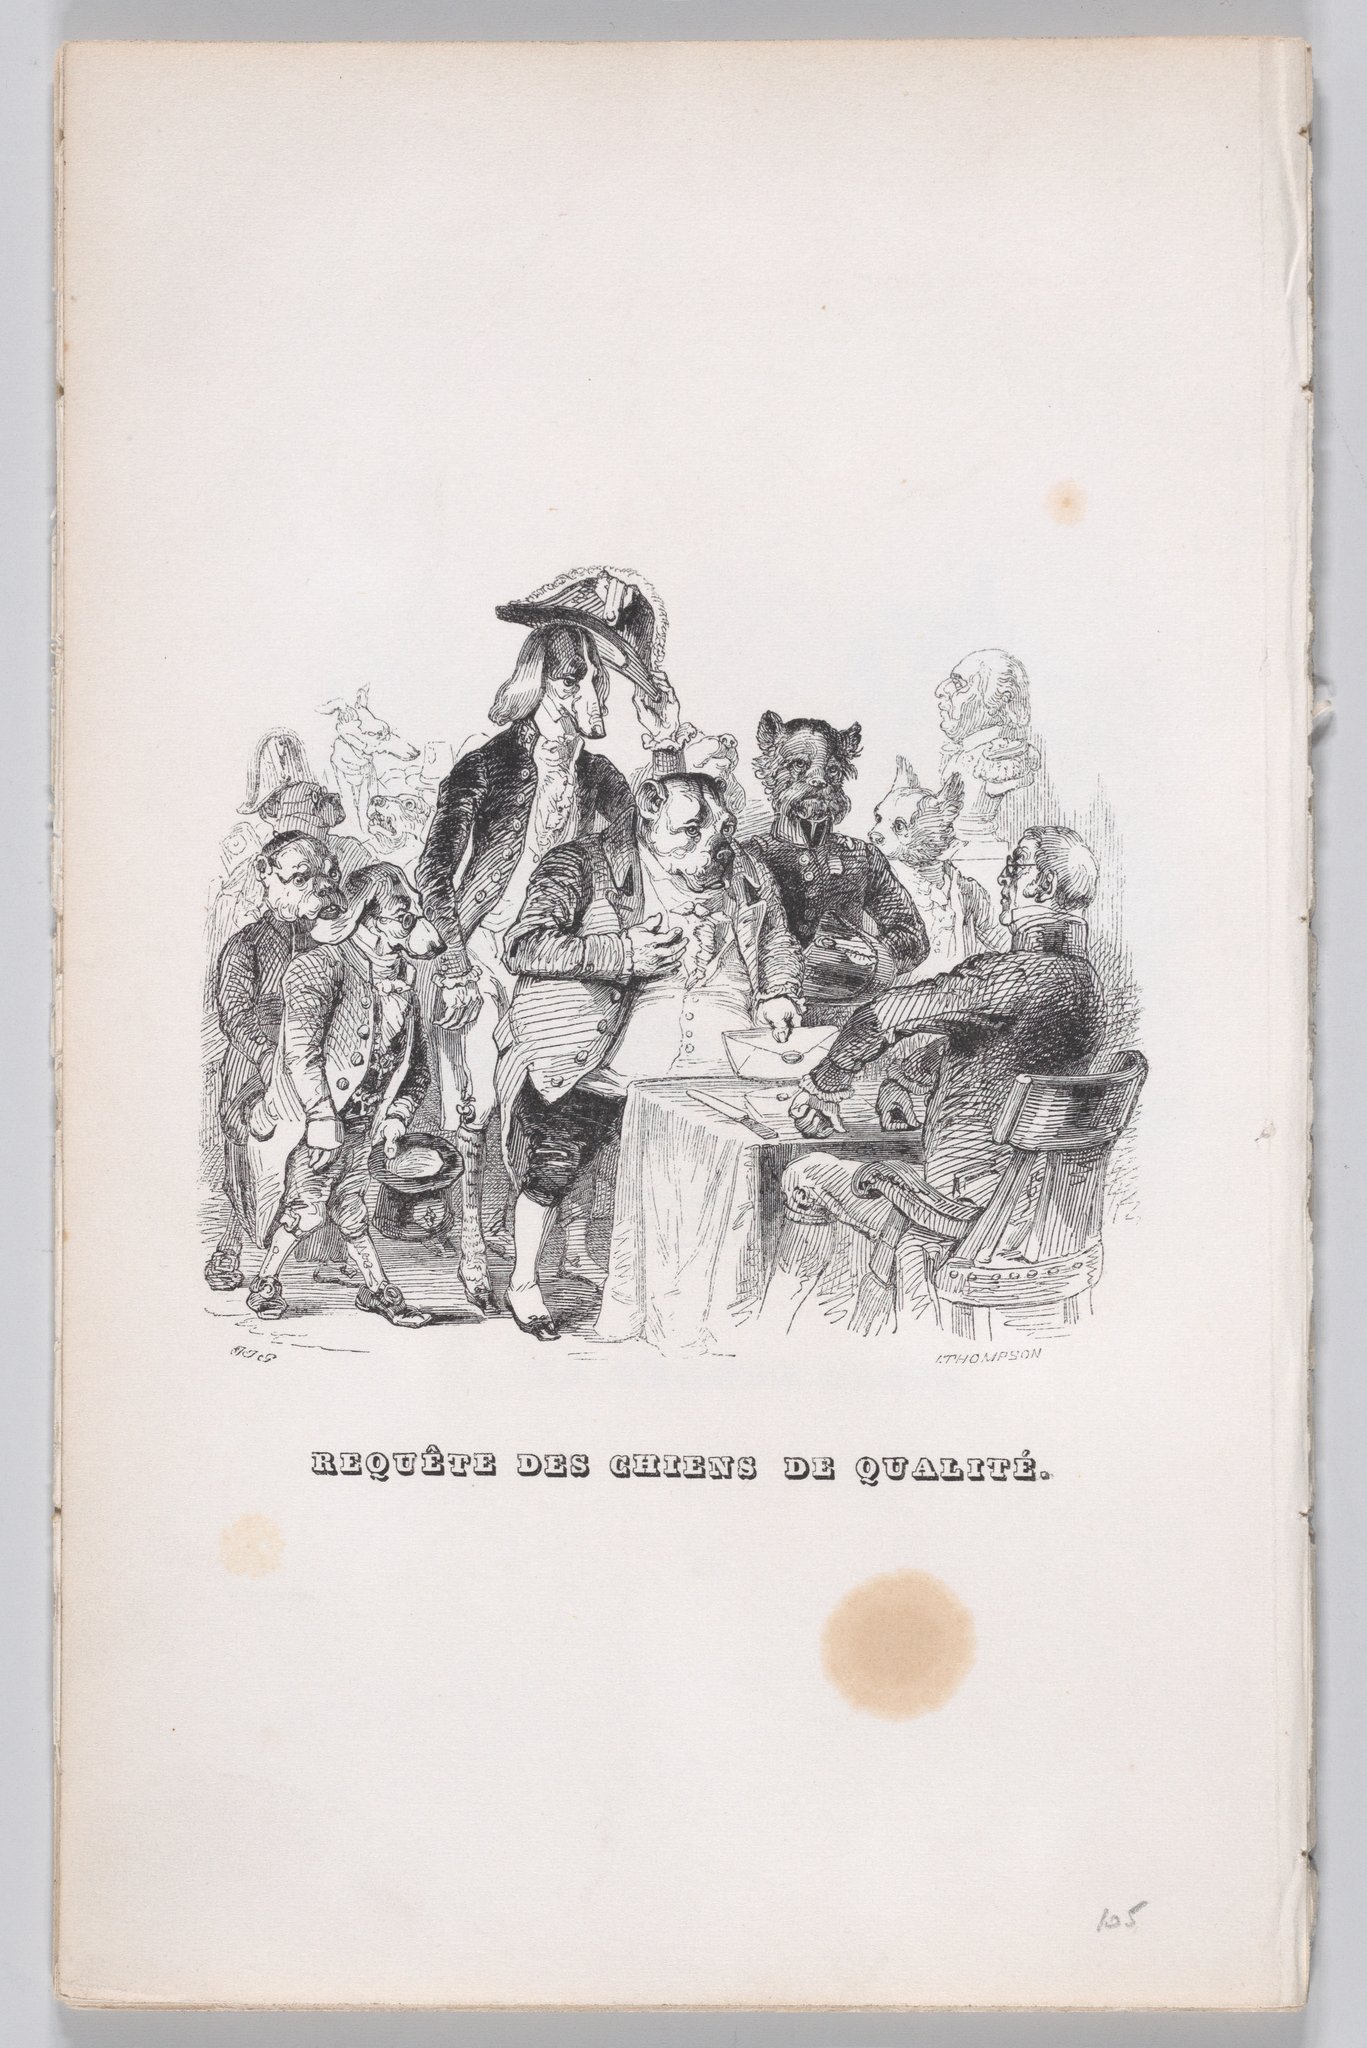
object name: print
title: Request of quality dogs, from "The Complete Works of Béranger"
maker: j. j. grandville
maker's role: illustrator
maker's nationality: french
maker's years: 1803-1847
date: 1836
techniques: engraving